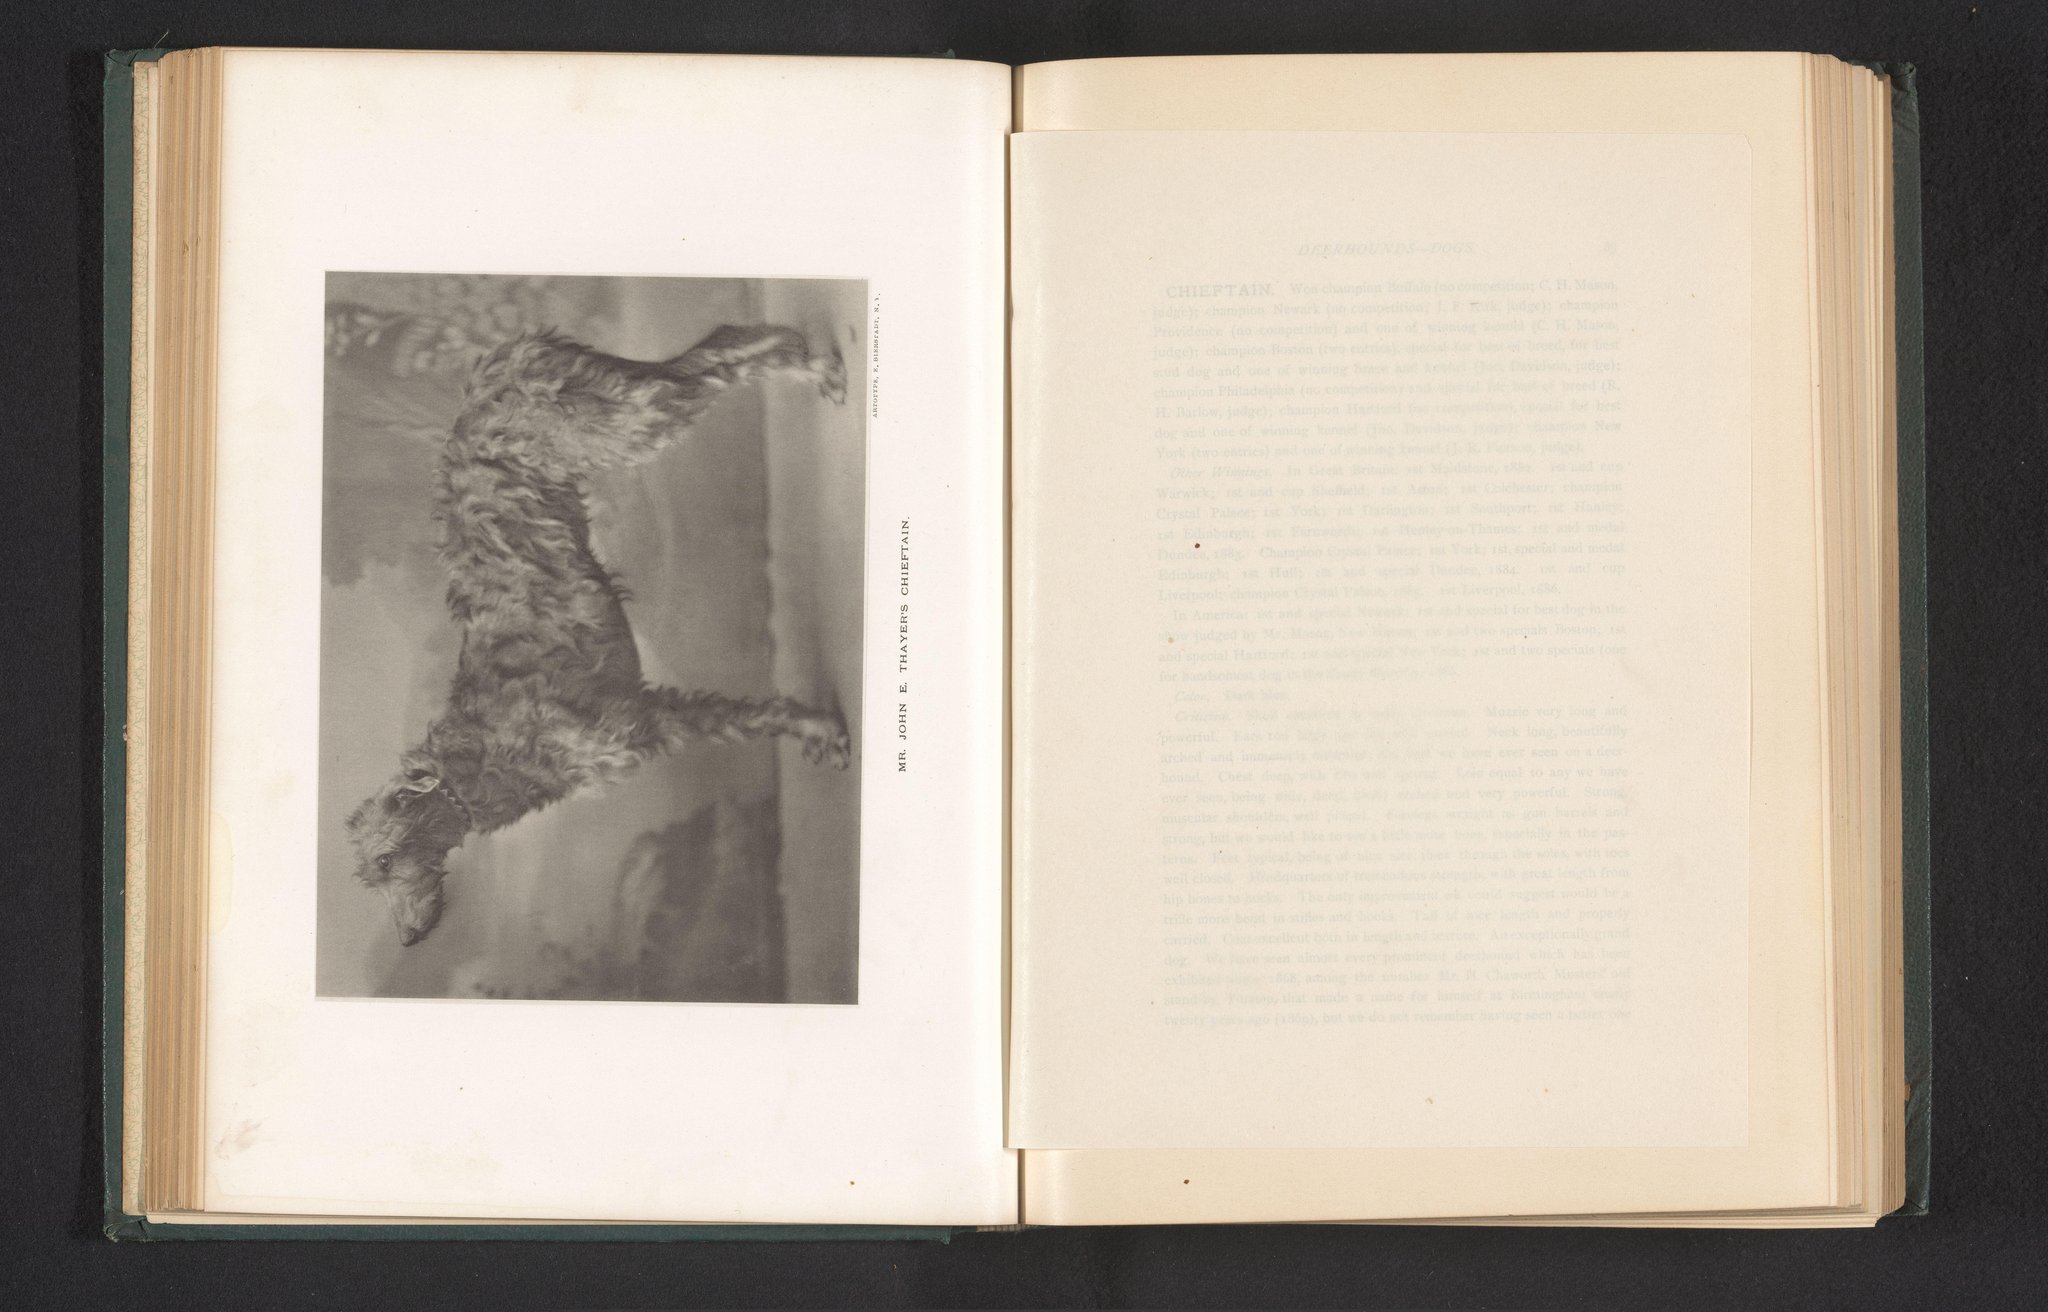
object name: photomechanical print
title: Mr. John E. Thayer's Chiertain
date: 1883-1888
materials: paper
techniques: photograph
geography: new york city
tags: dog (with name of kind)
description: Prent tegenover pagina 85, achter semi-transparante omslag.